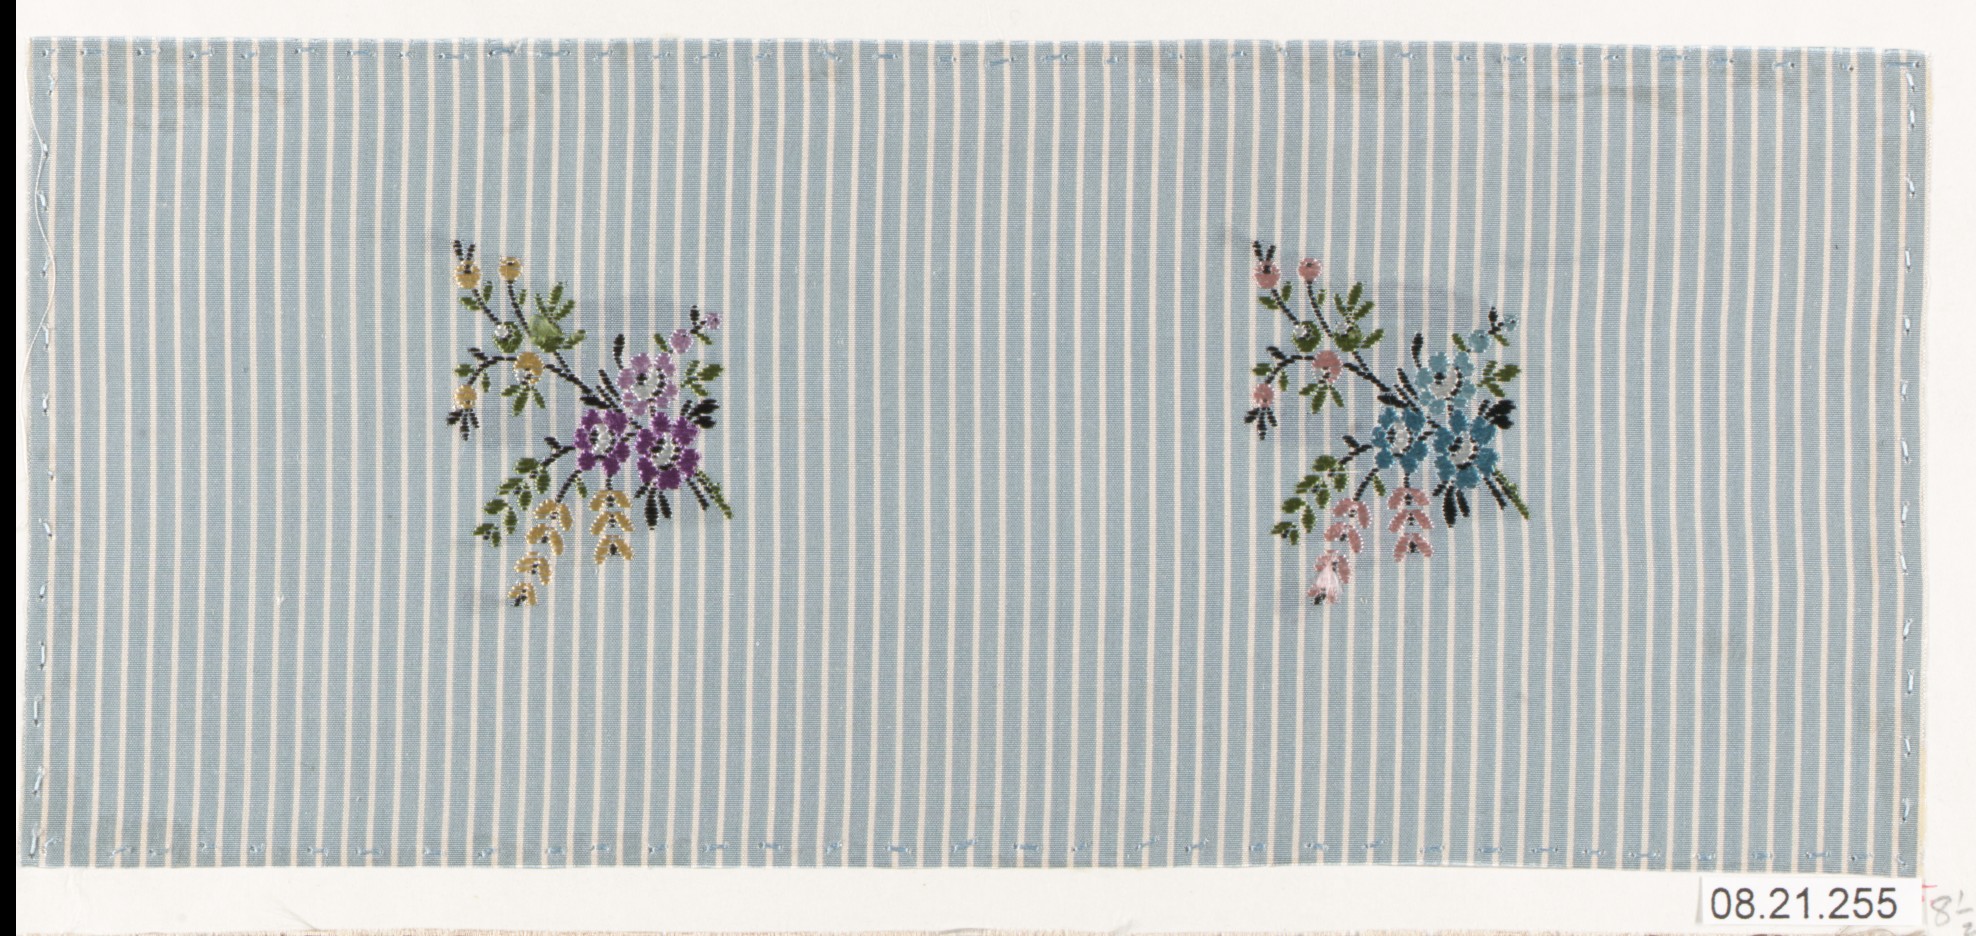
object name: textile sample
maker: Anonymous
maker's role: designer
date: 1900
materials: silk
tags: flowers